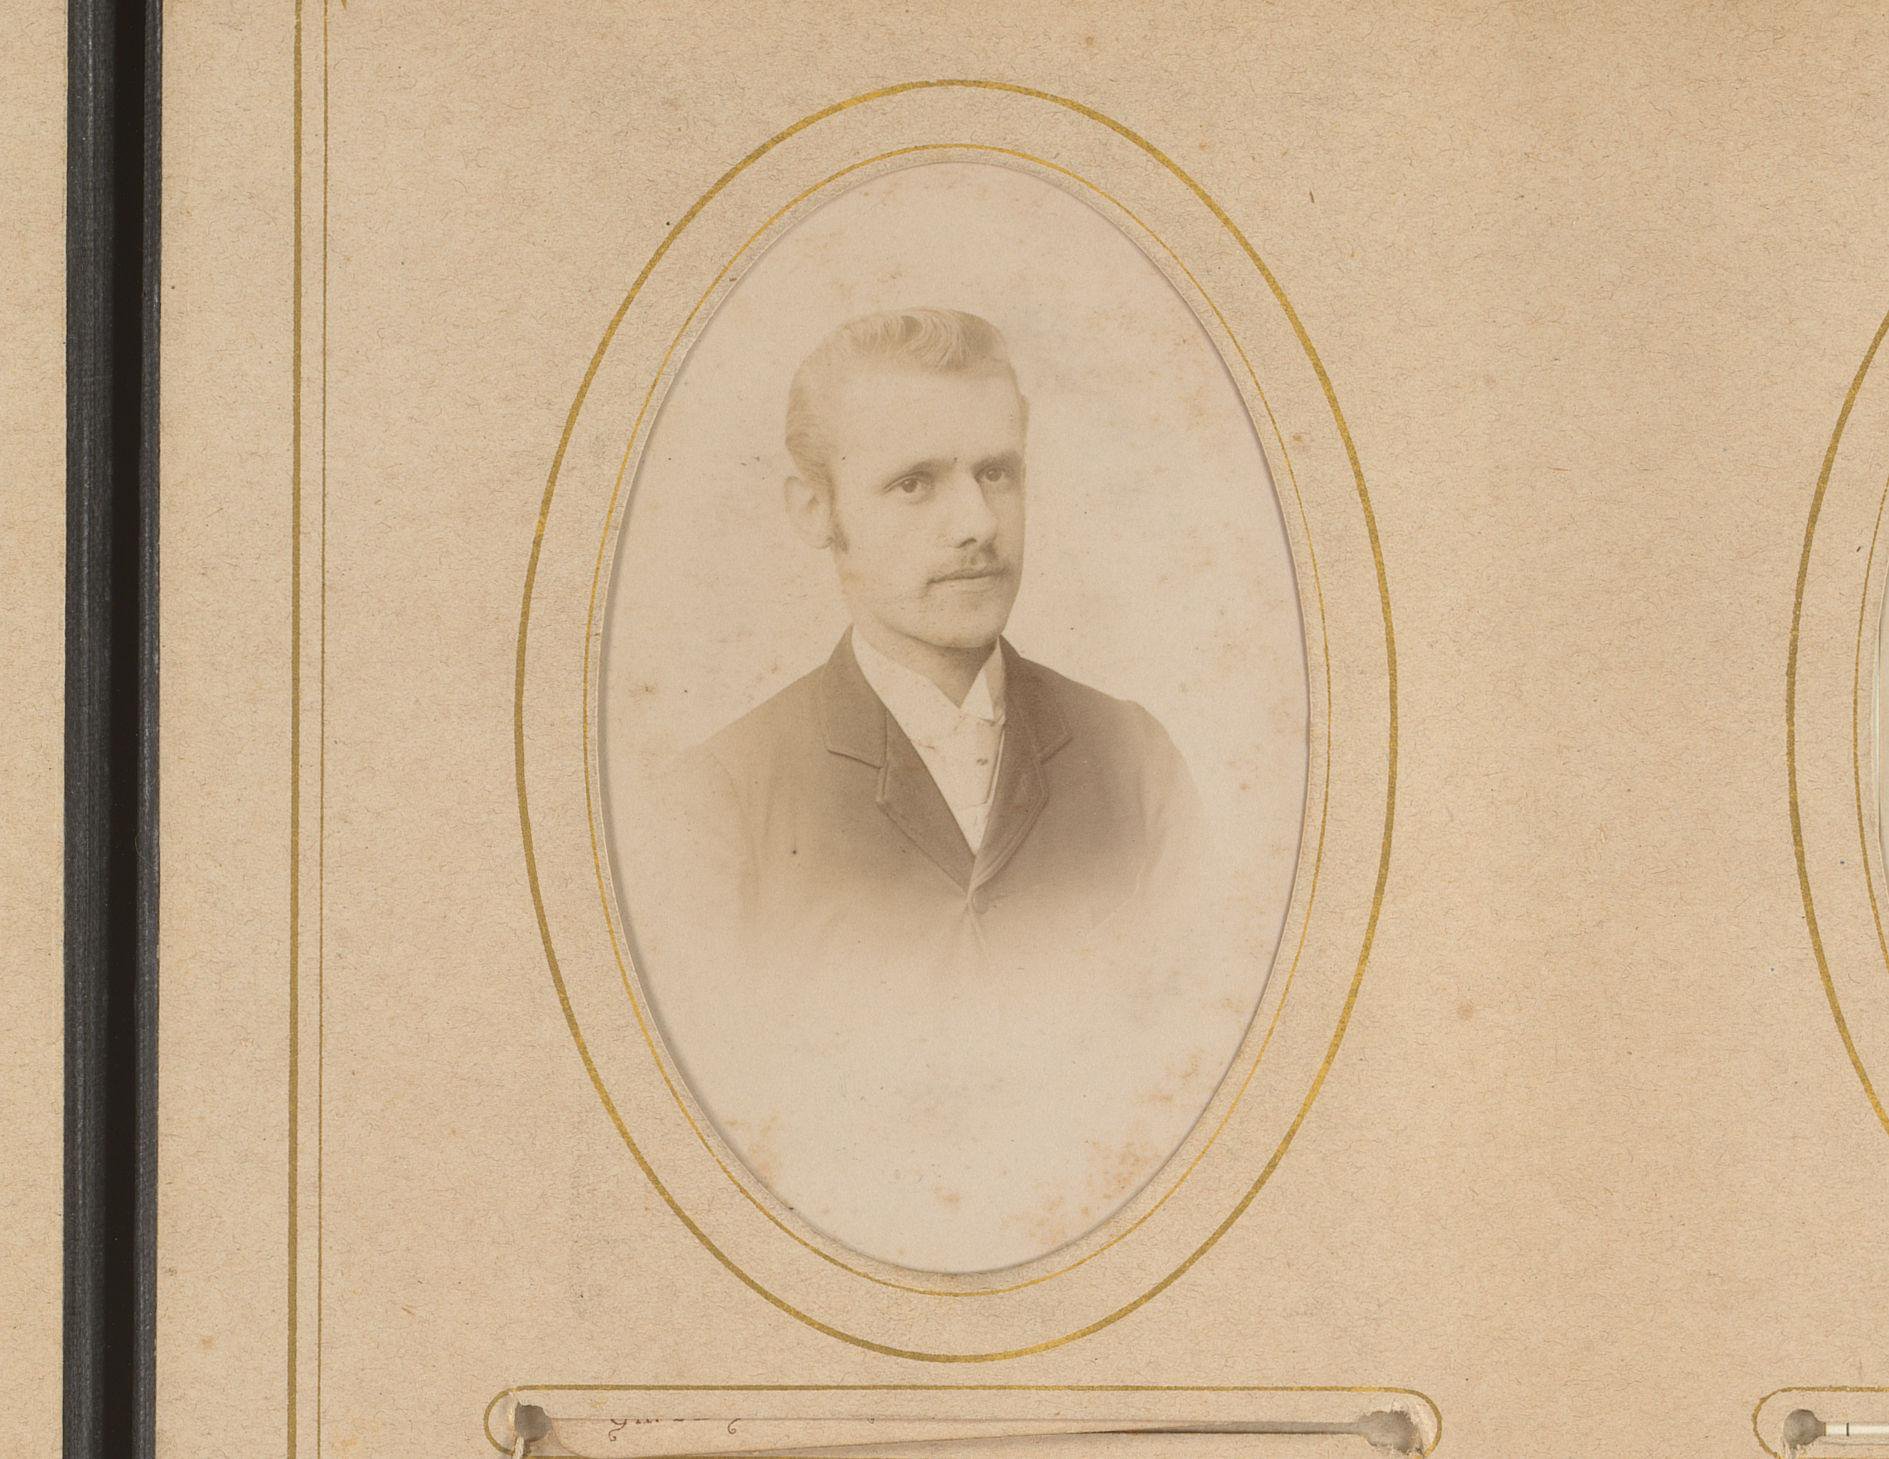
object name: album leaf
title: Portret van een man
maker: Anonymous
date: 1860-1900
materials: cardboard, photographic support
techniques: albumen print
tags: adult man, historical persons